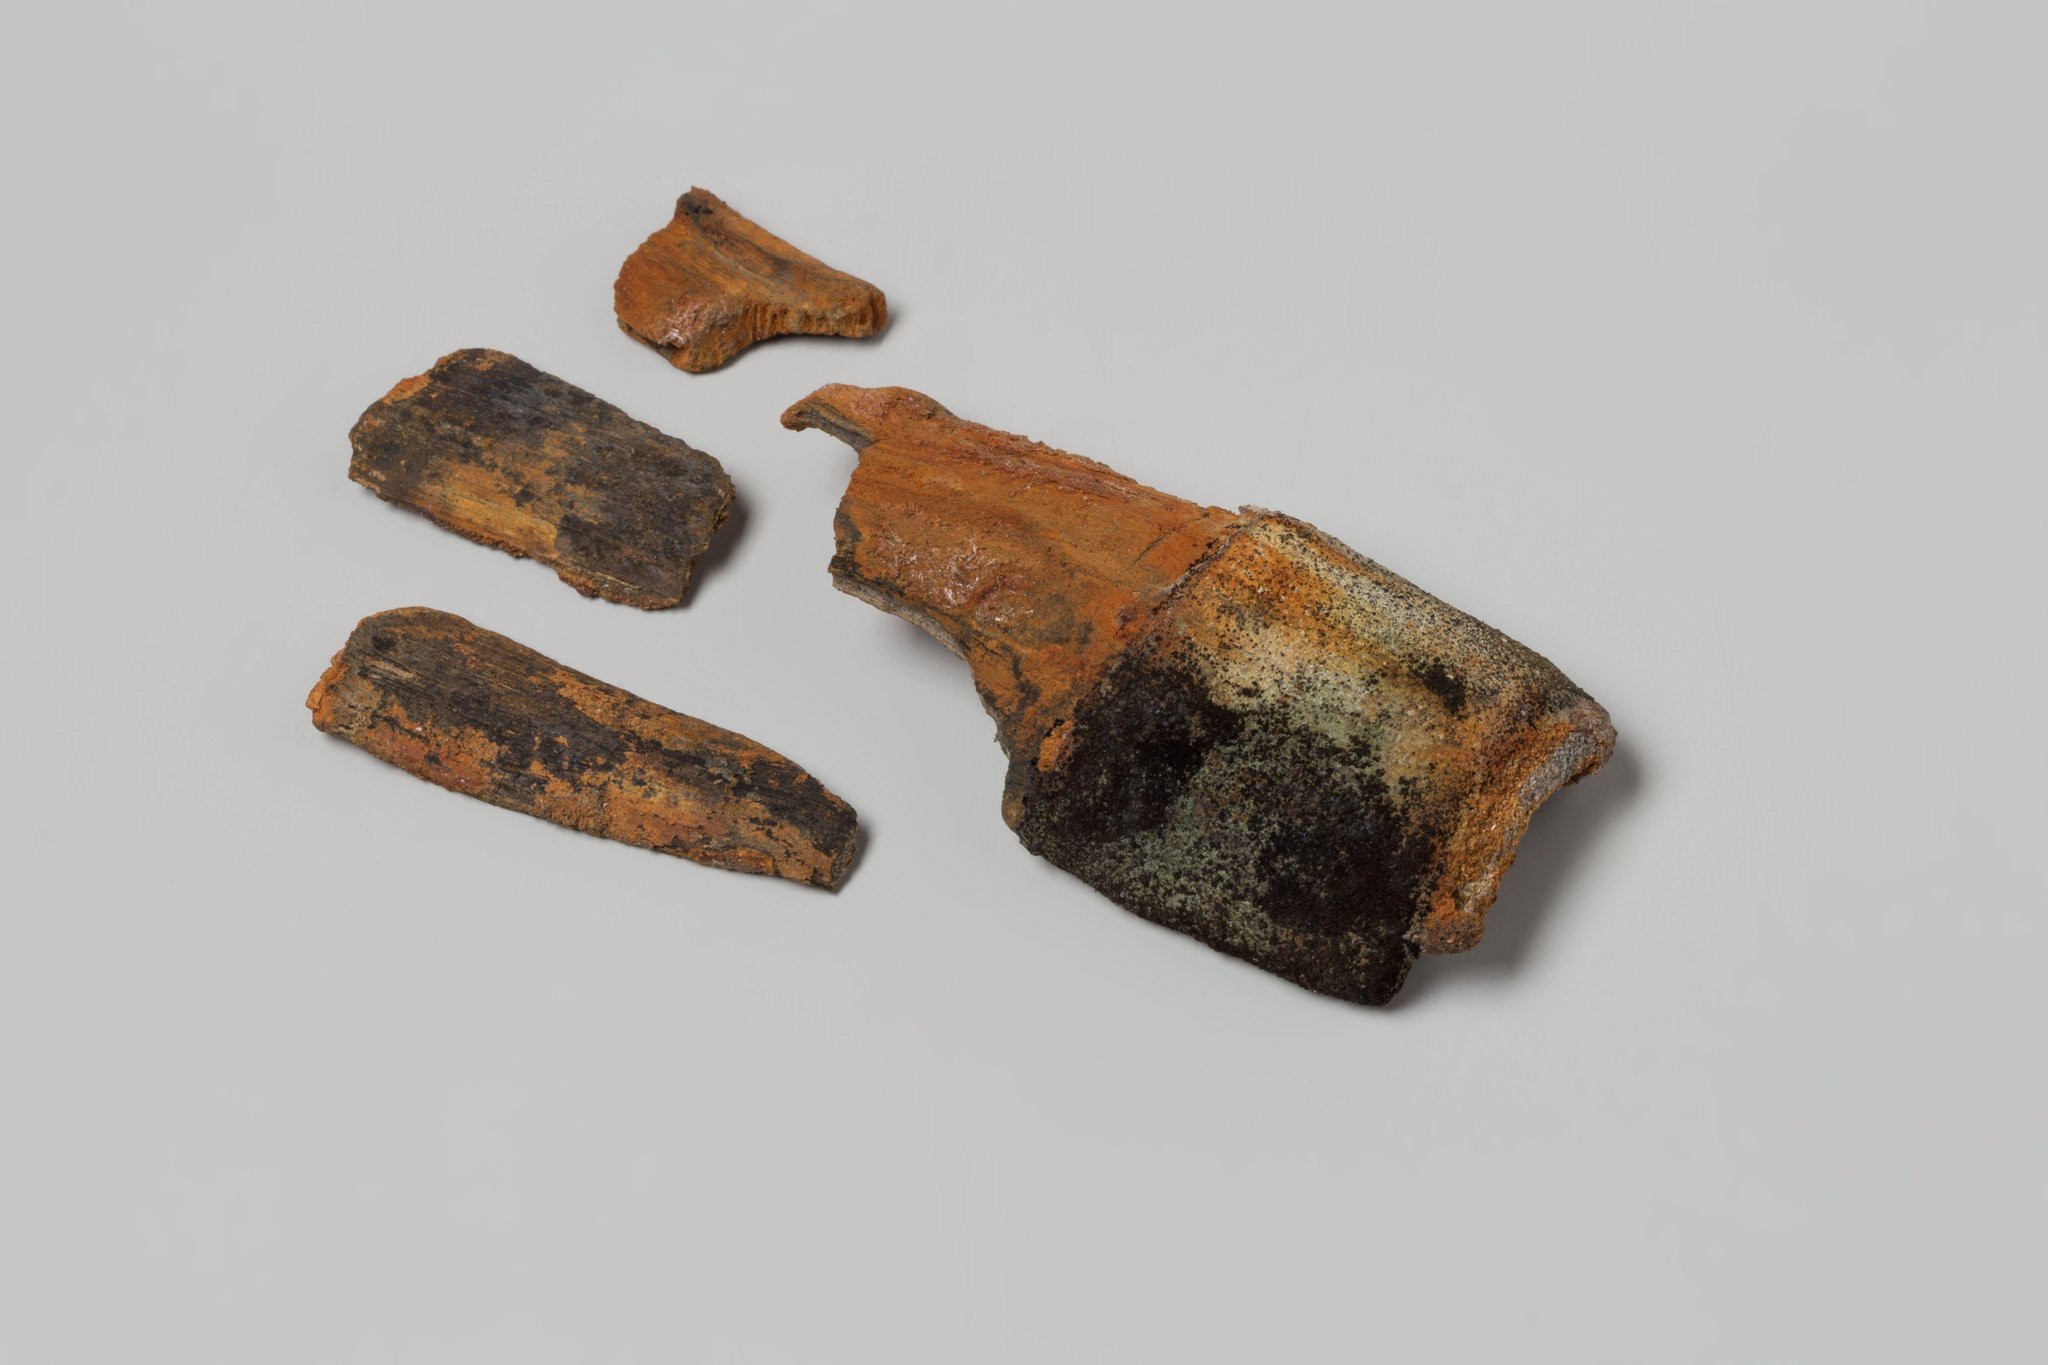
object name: musket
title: Fragment van een musket uit het wrak van de in 1735 vergane Oost-Indiëvaarder 't Vliegend Hart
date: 1700-1735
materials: metal, wood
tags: 't vliegend hart (schip), verenigde oostindische compagnie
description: Het halfronde stuk (naald)hout maakte vermoedelijk deel uit van een musket (stokband).